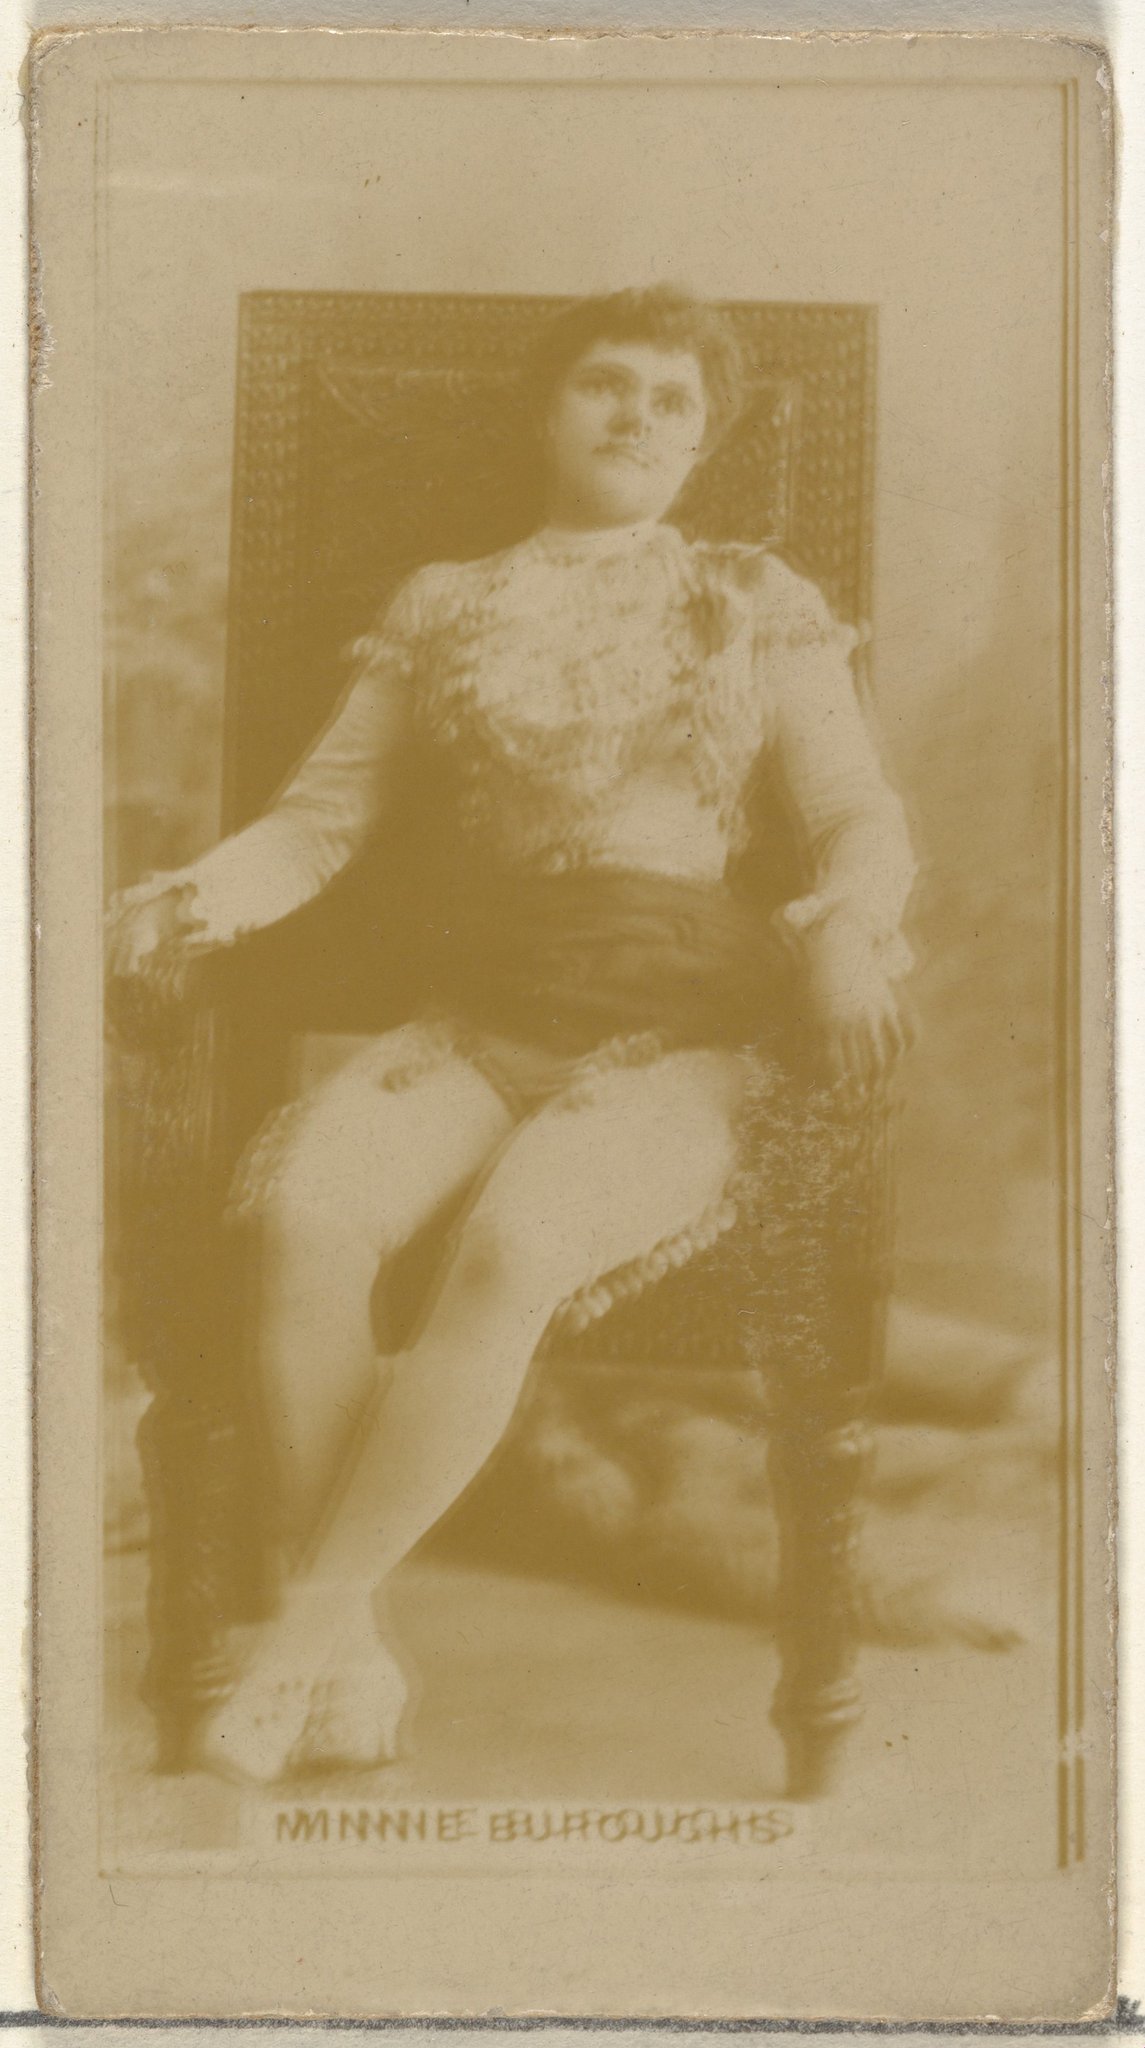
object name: photograph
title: Minnie Buroughs, from the Actors and Actresses series (N145-8) issued by Duke Sons & Co. to promote Duke Cigarettes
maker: w. duke, sons & co.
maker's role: publisher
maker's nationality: american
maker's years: 1870-1920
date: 1891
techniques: albumen silver print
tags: portraits,women,actresses